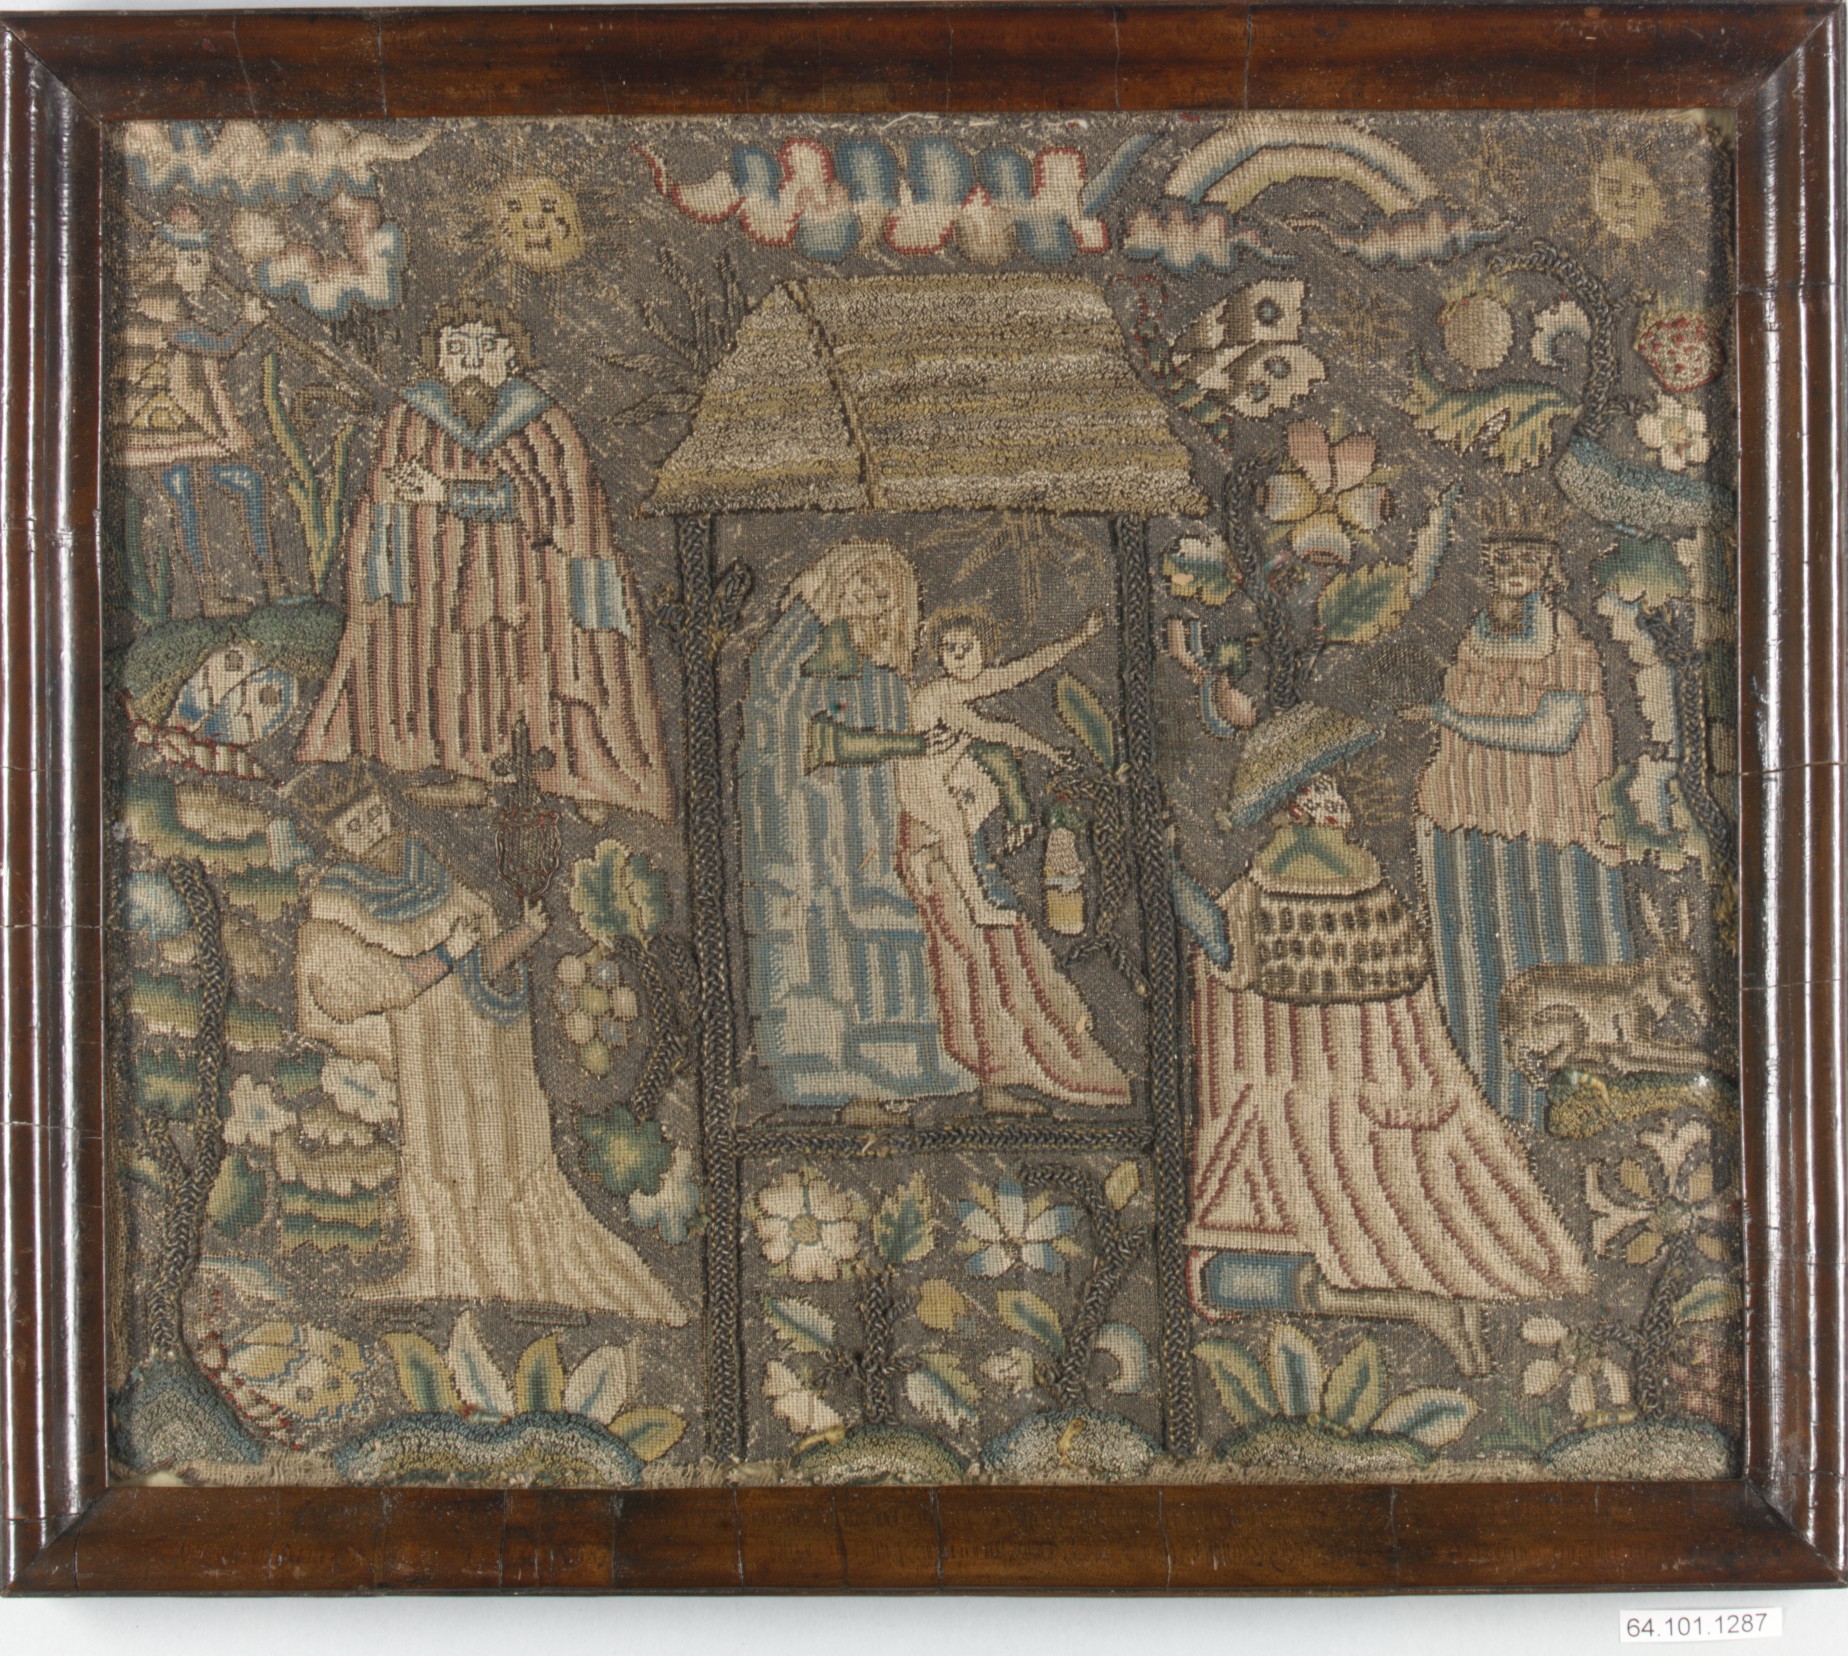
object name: embroidered picture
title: The Adoration of the Magi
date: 1601-1625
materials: canvas, metal thread, silk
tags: butterflies,virgin mary,jesus,adoration of the magi